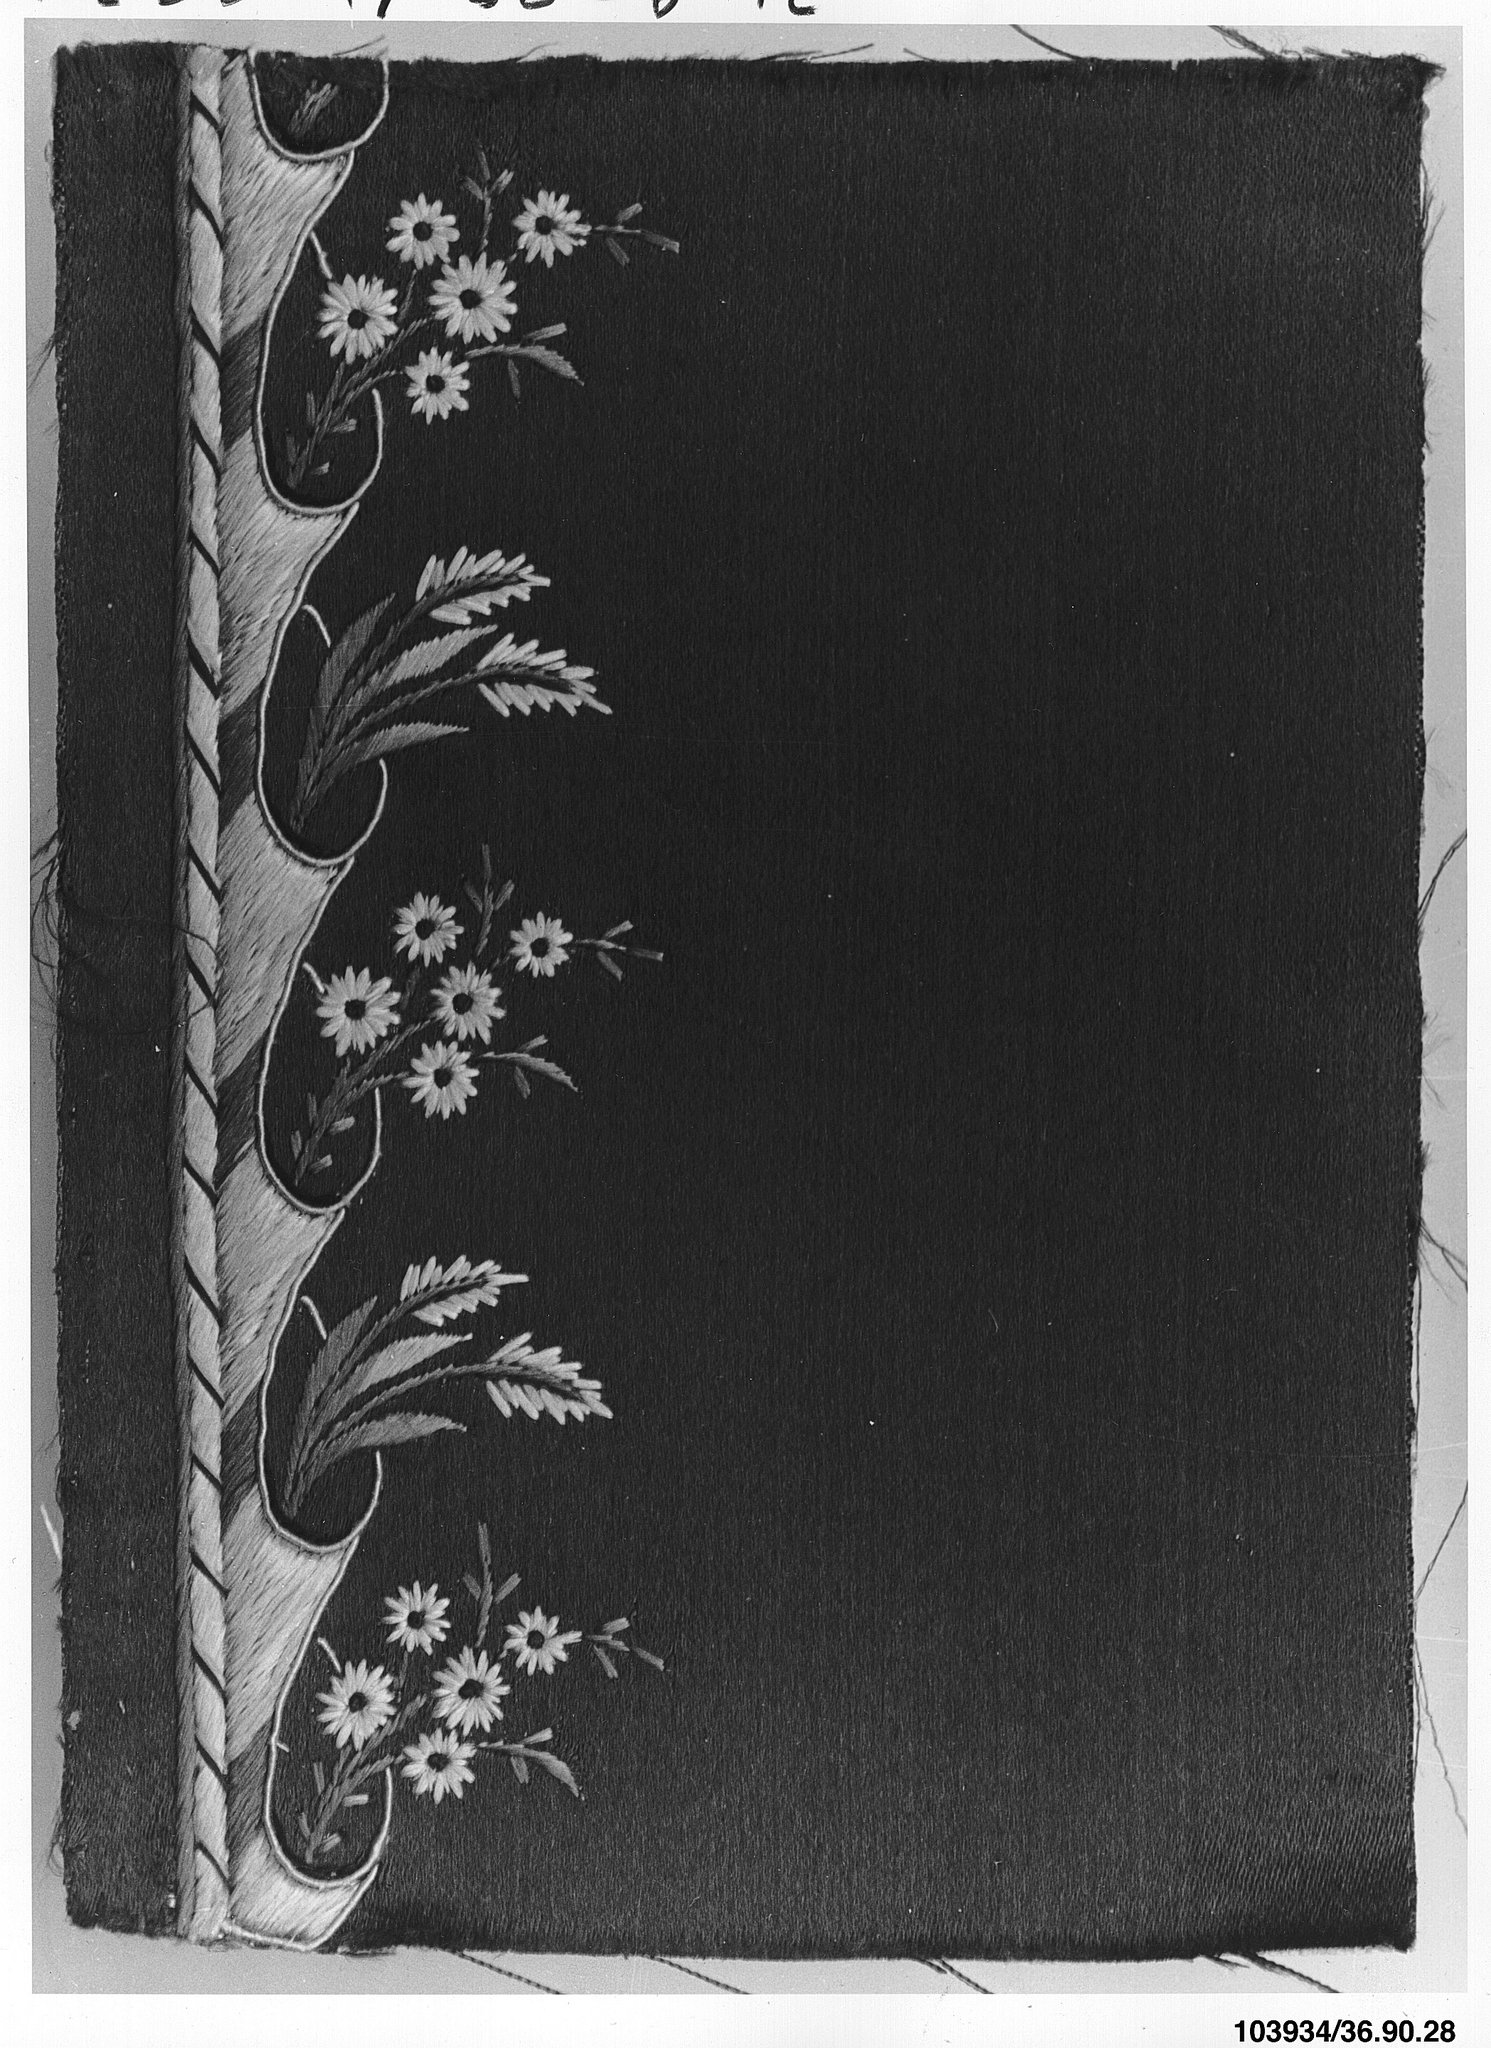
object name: sample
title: Embroidery sample for a man’s suit or waistcoat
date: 1785-1815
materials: silk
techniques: embroidery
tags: flowers